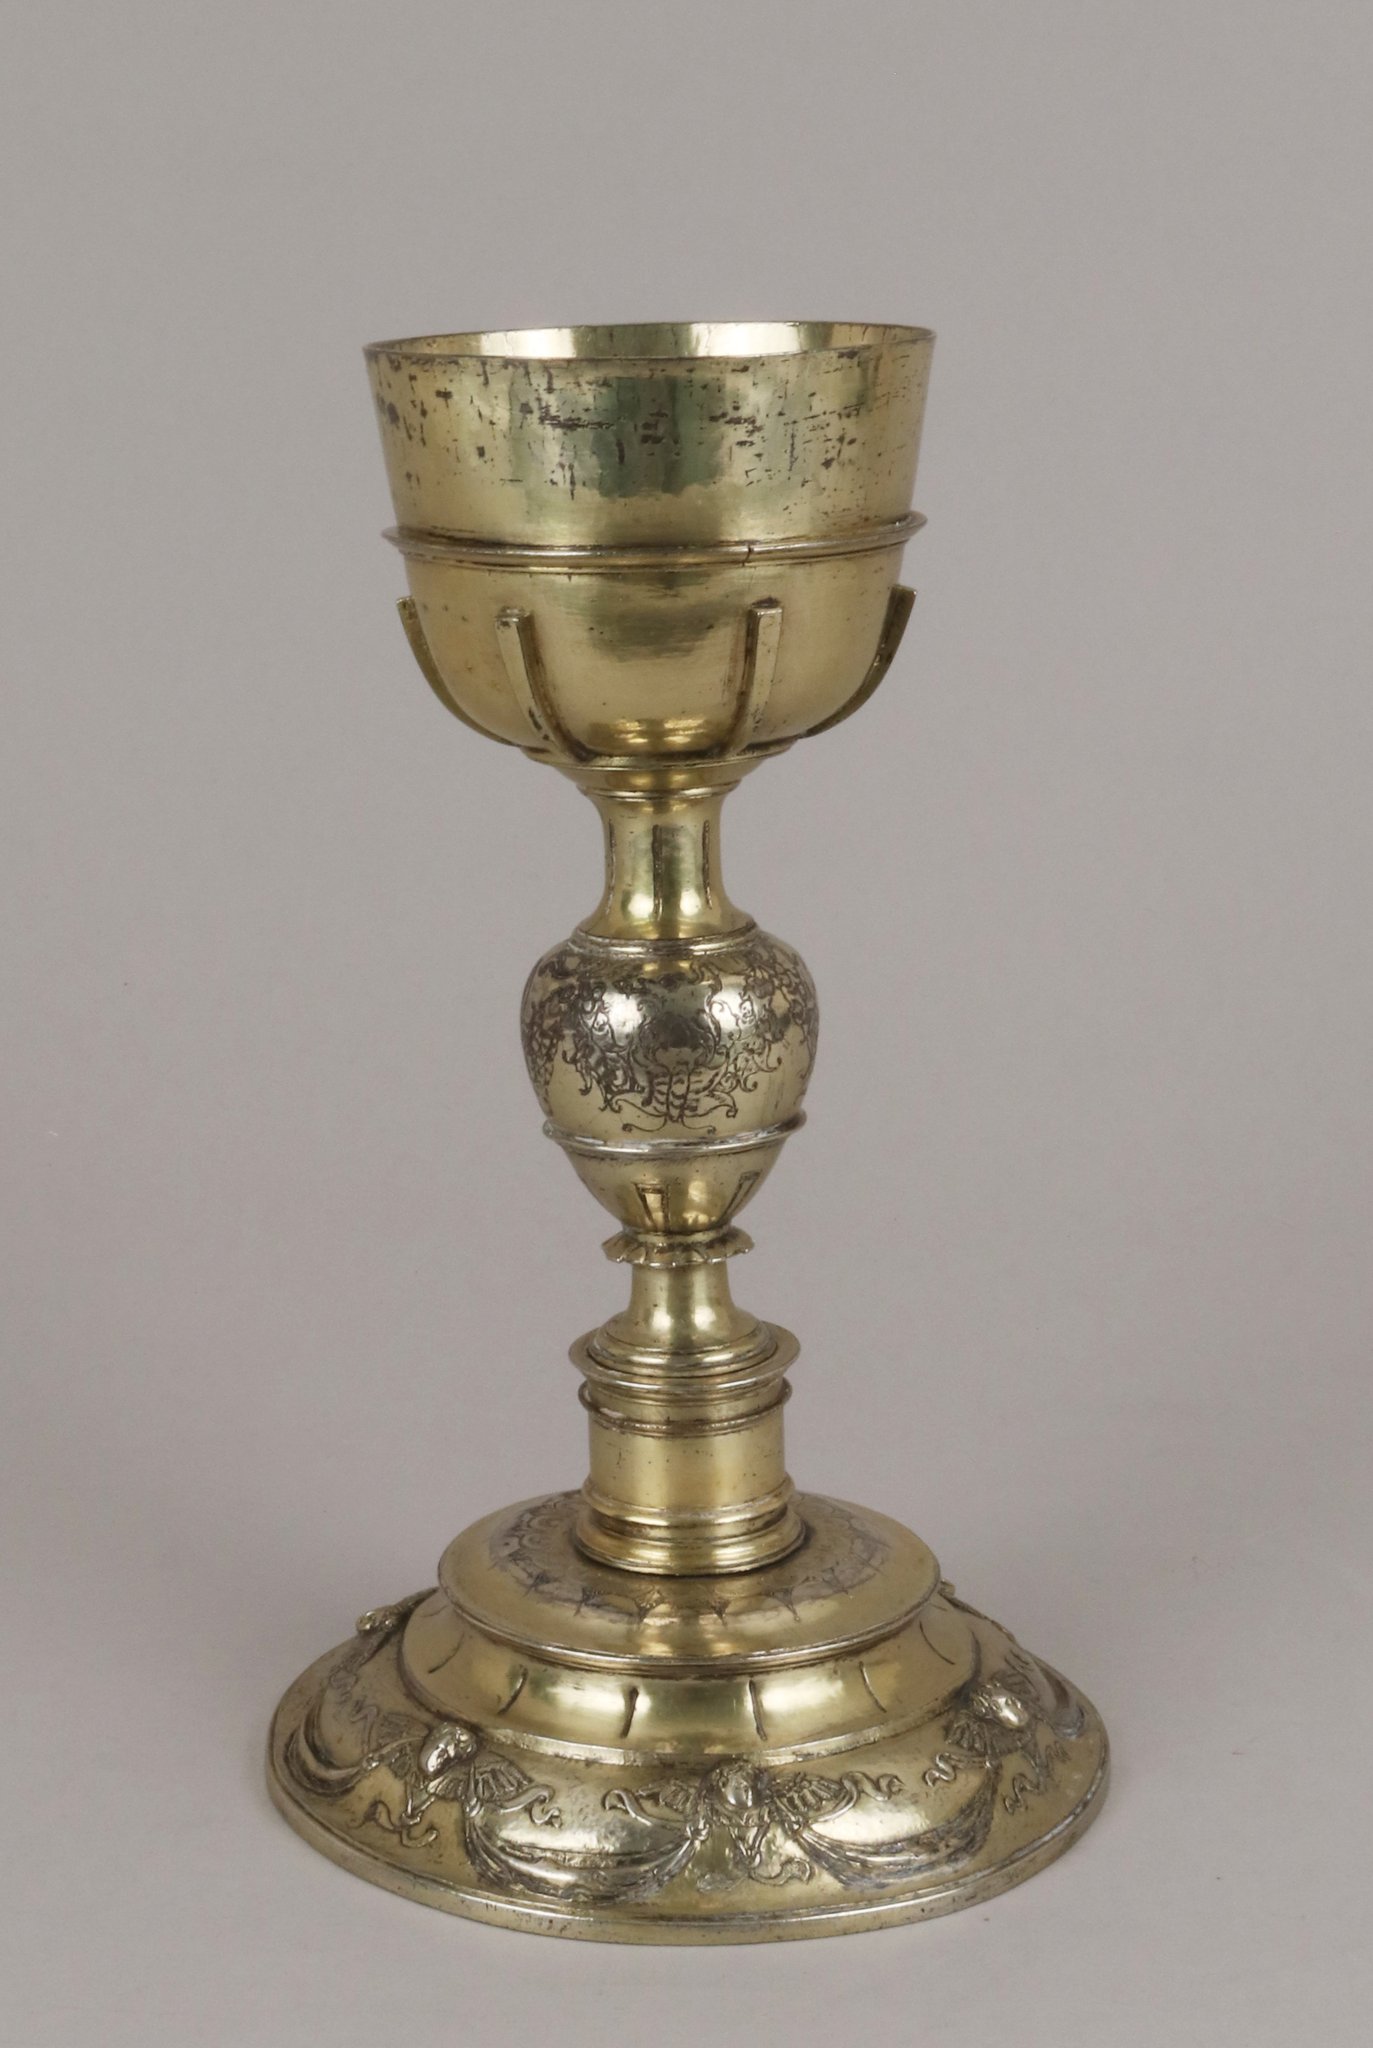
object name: chalice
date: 1601-1633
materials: silver gilt